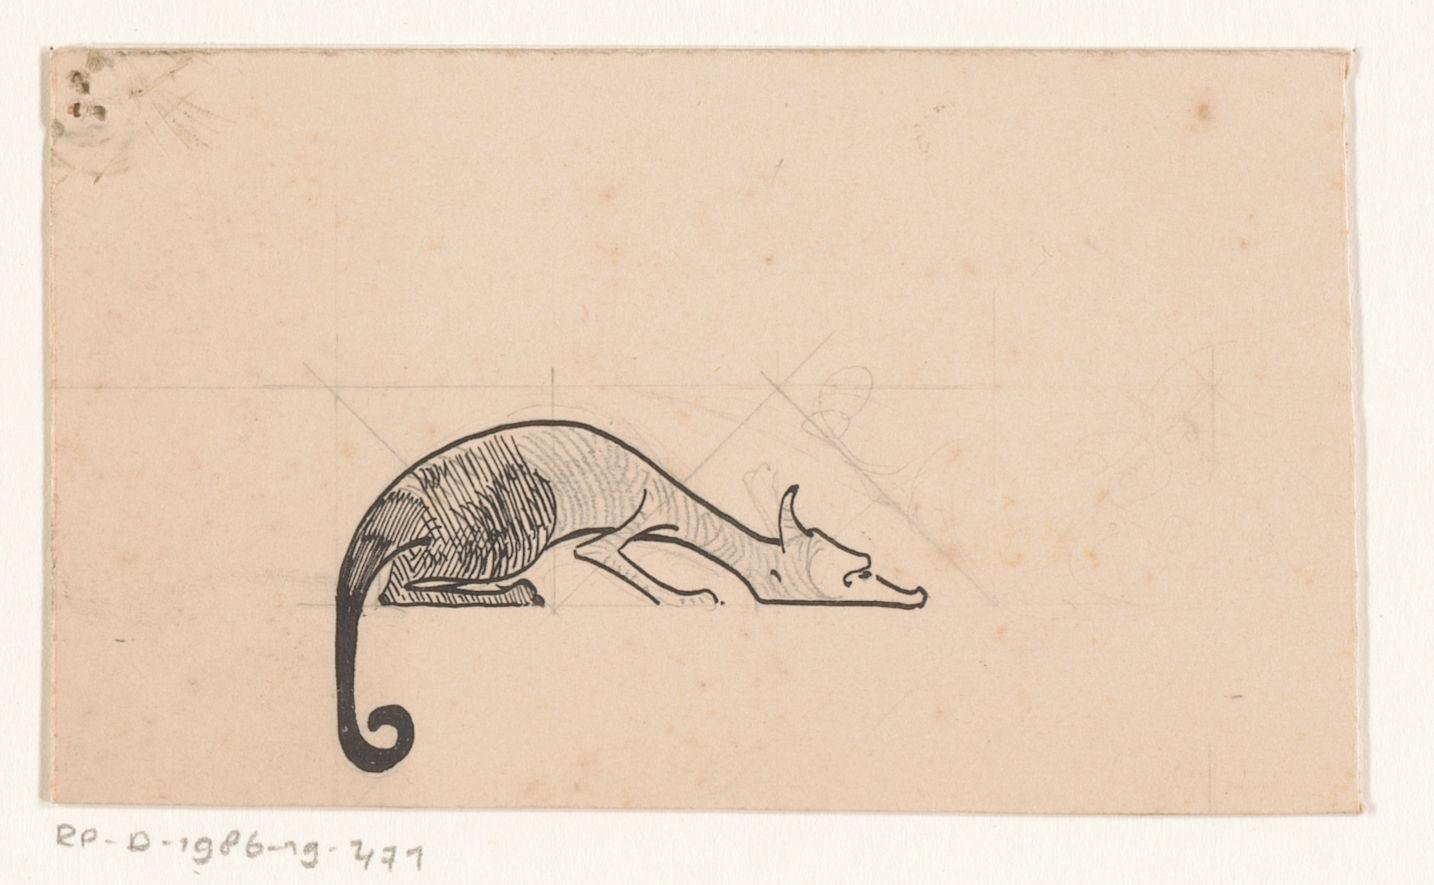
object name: drawing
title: Gestileerd dier met gekrulde staart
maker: reinier willem petrus de vries (1874-1953)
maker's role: draughtsman, print maker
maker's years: 1874-1953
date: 1884-1952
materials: ink, paper, pencil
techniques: pen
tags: animals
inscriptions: collector's mark: ‘R:MVS.’